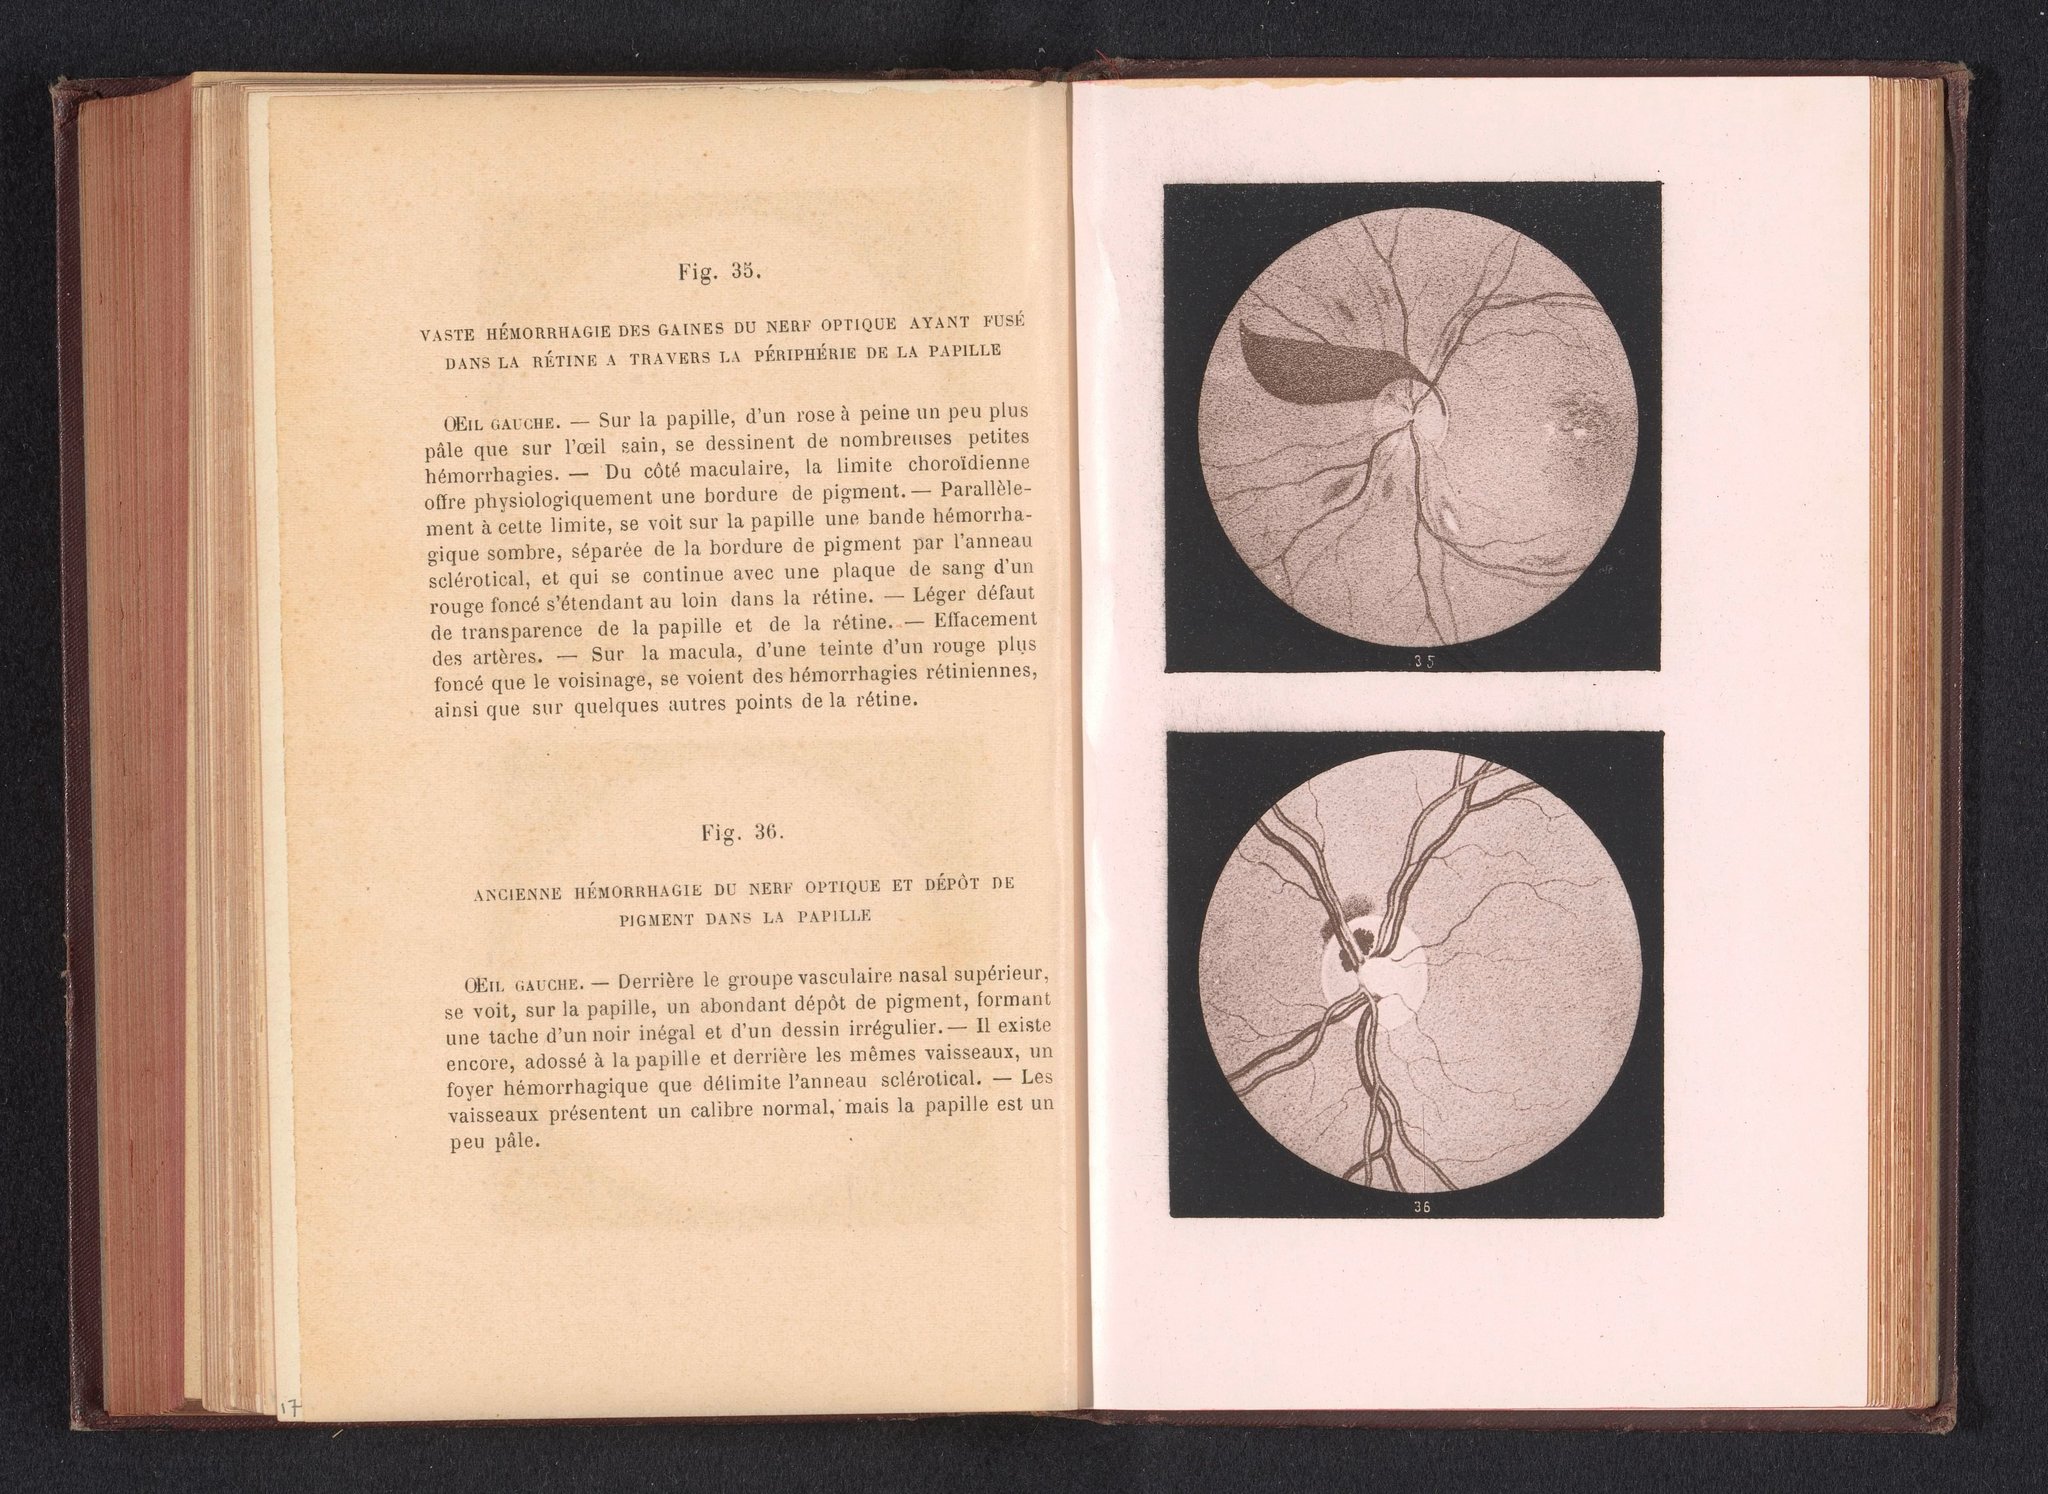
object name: photomechanical print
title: Fotoreproductie van twee anatomische tekeningen van bloedingen in een oog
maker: Anonymous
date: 1871-1891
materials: paper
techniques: photograph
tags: anatomy (non-medical), eyes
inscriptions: inscription: ‘Fig. 35. Vaste hémorrhagie des gaines du nerf optique ayant fusé dans la rétine a travers la périphérie de la papille Fig. 36. Ancienne hémorrhagie du nerf optique et dépôt de pigment dans la papille’